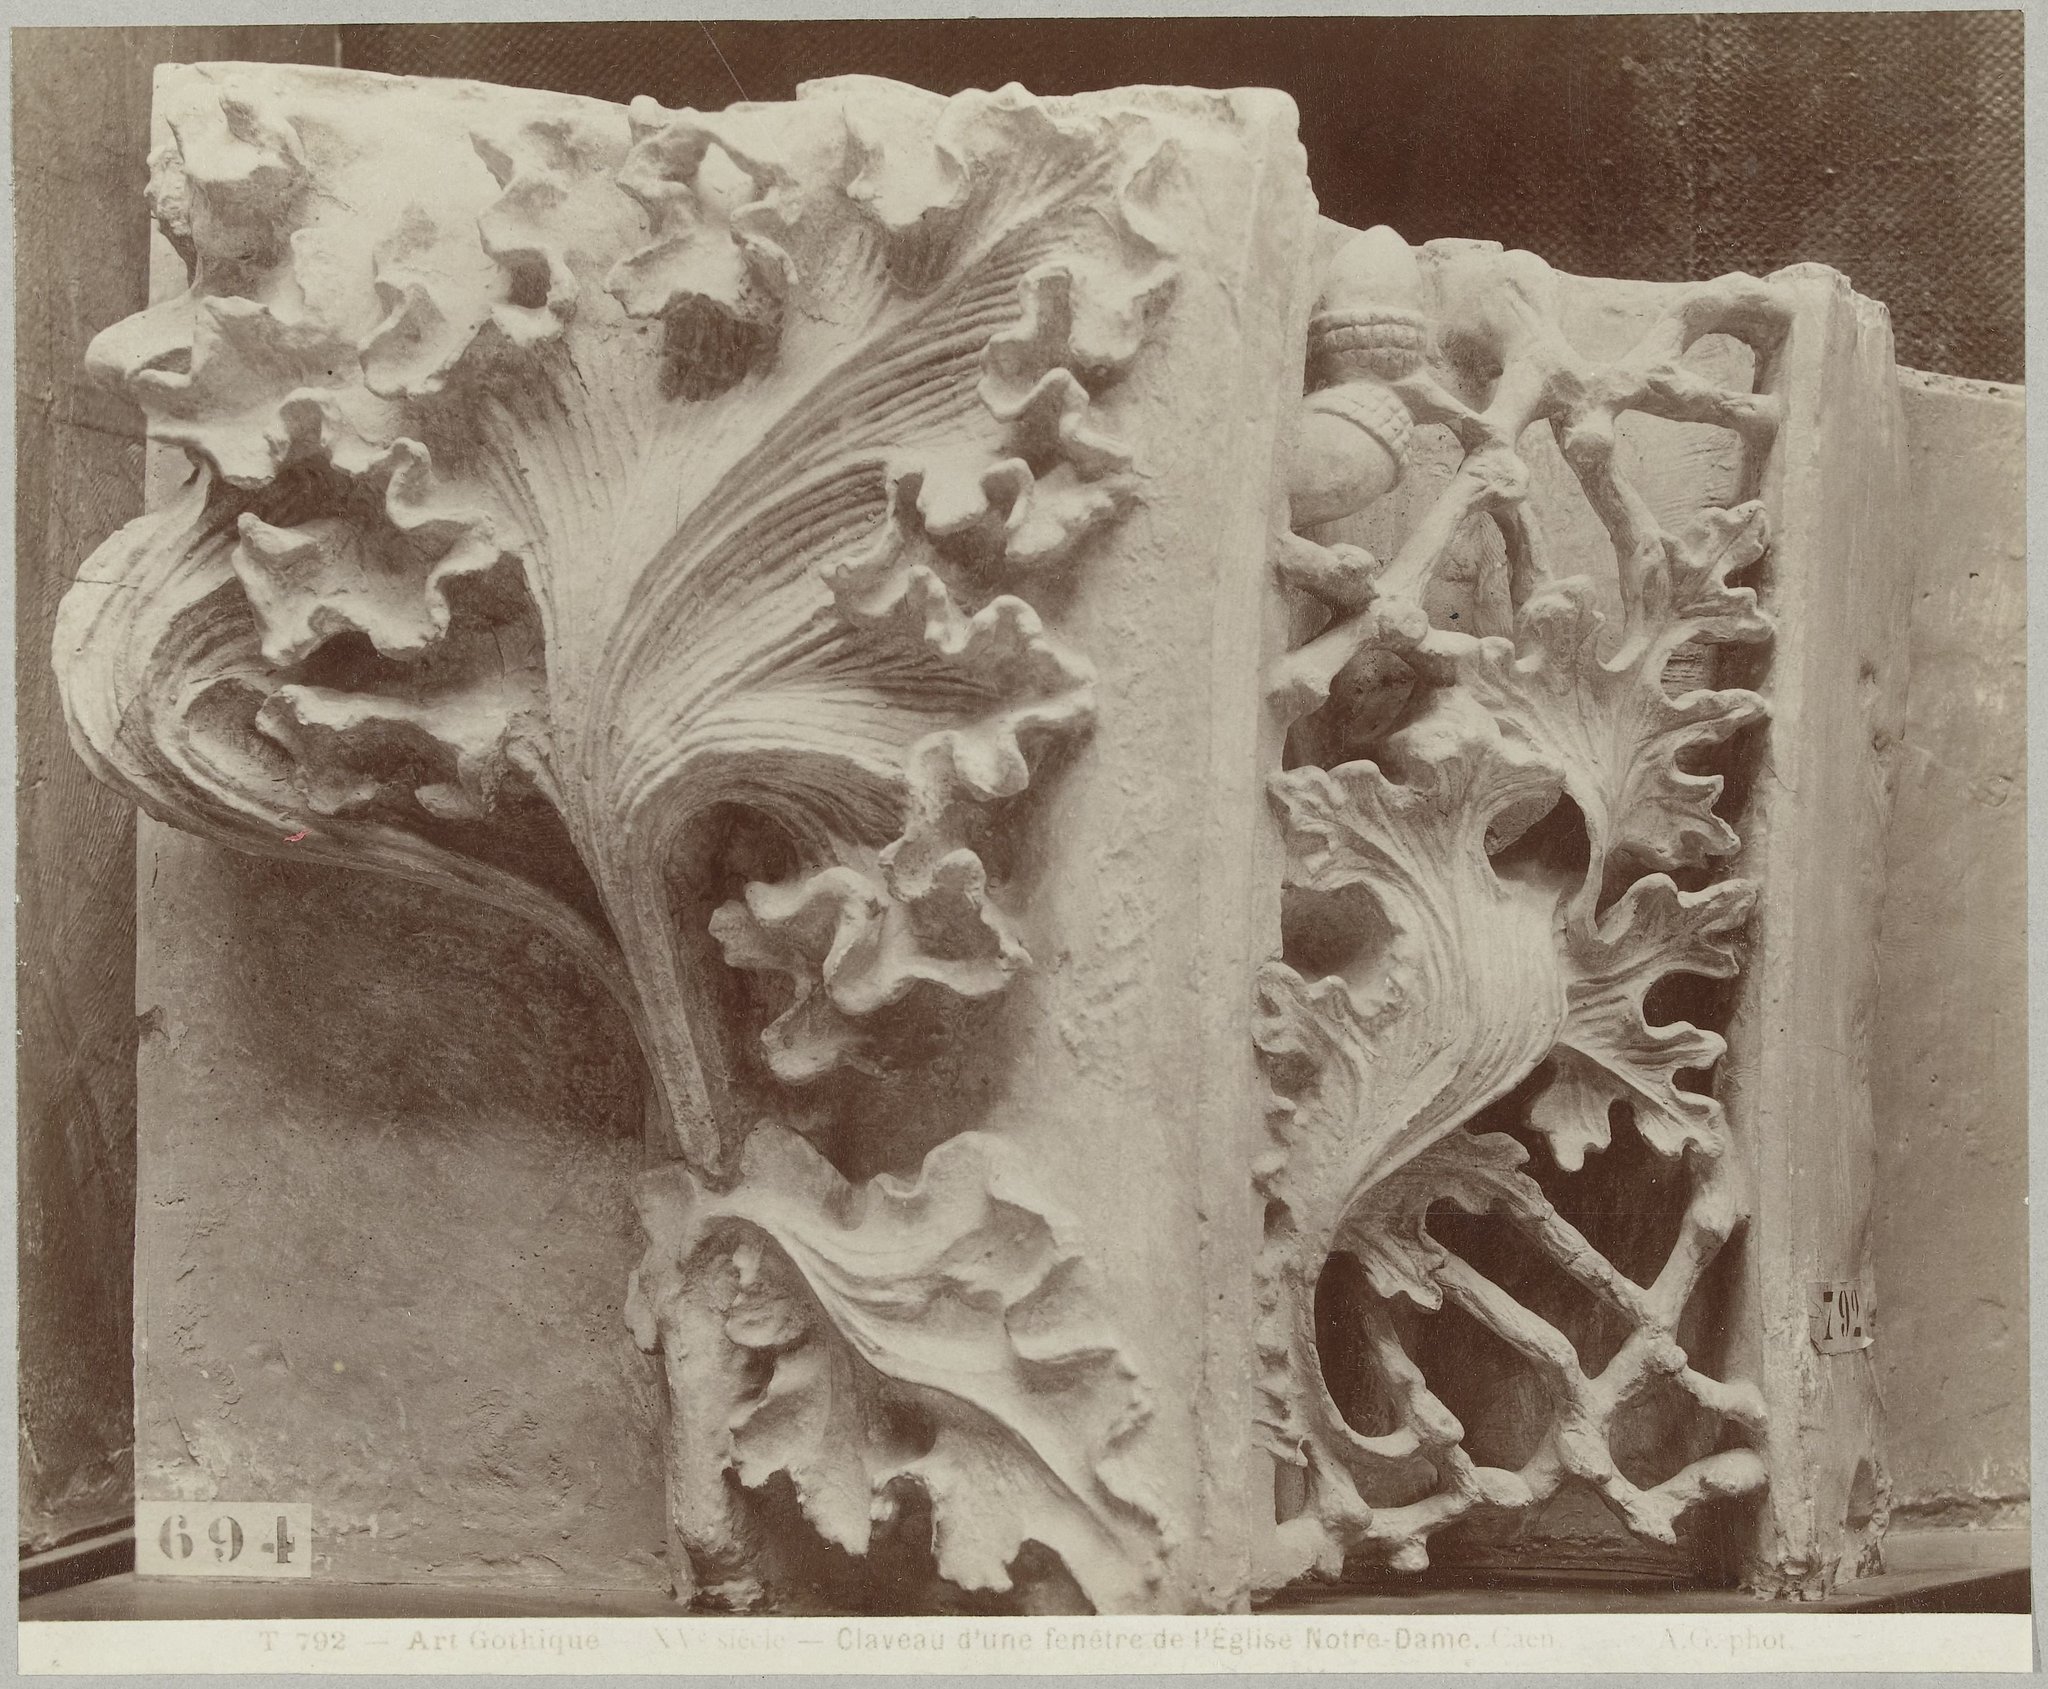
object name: photograph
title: Boogsteen van een venster van de Église Saint-Sauveur te Caen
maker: adolphe giraudon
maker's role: publisher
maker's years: 1849-1929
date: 1860-1900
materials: cardboard, paper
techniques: albumen print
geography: caen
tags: architectural detail, church (exterior), piece of sculpture, reproduction of a piece of sculpture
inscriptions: number: ‘694/ T 792’